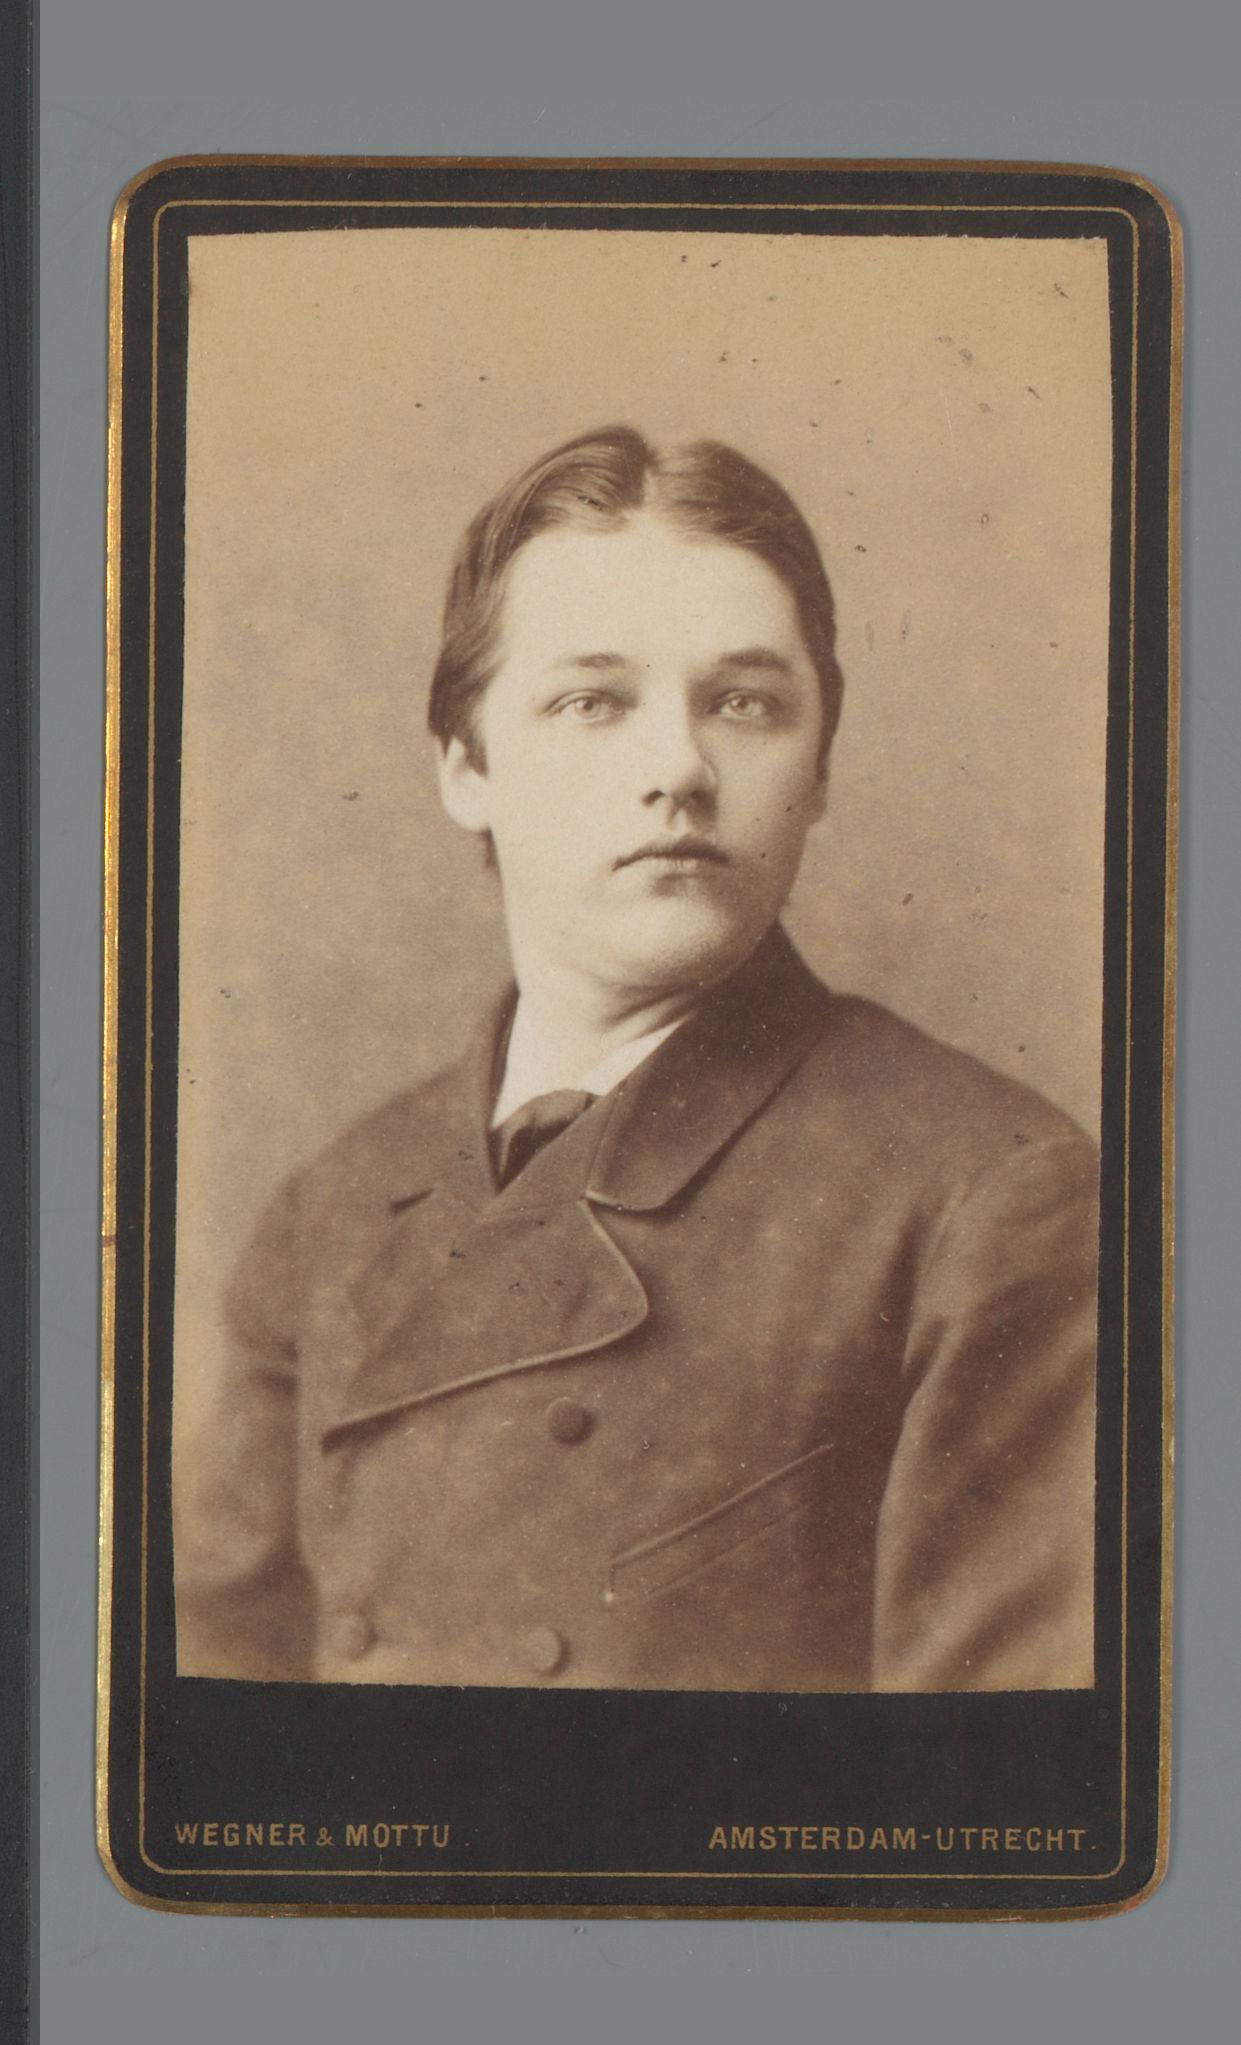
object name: carte de visite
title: Portret van Lucas Jonker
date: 1870-1900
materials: cardboard, photographic support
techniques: albumen print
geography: amsterdam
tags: historical persons, amsterdam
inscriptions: inscription: ‘Lucas Jonker/ 1861-1926’, workshop stamp: ‘Photographisch Artistisch Atelier van/ Wegner & Mottu/ Amsterdam, Rokin over de Bank 138/ Utrecht, Hamburgerstraat, F 237’